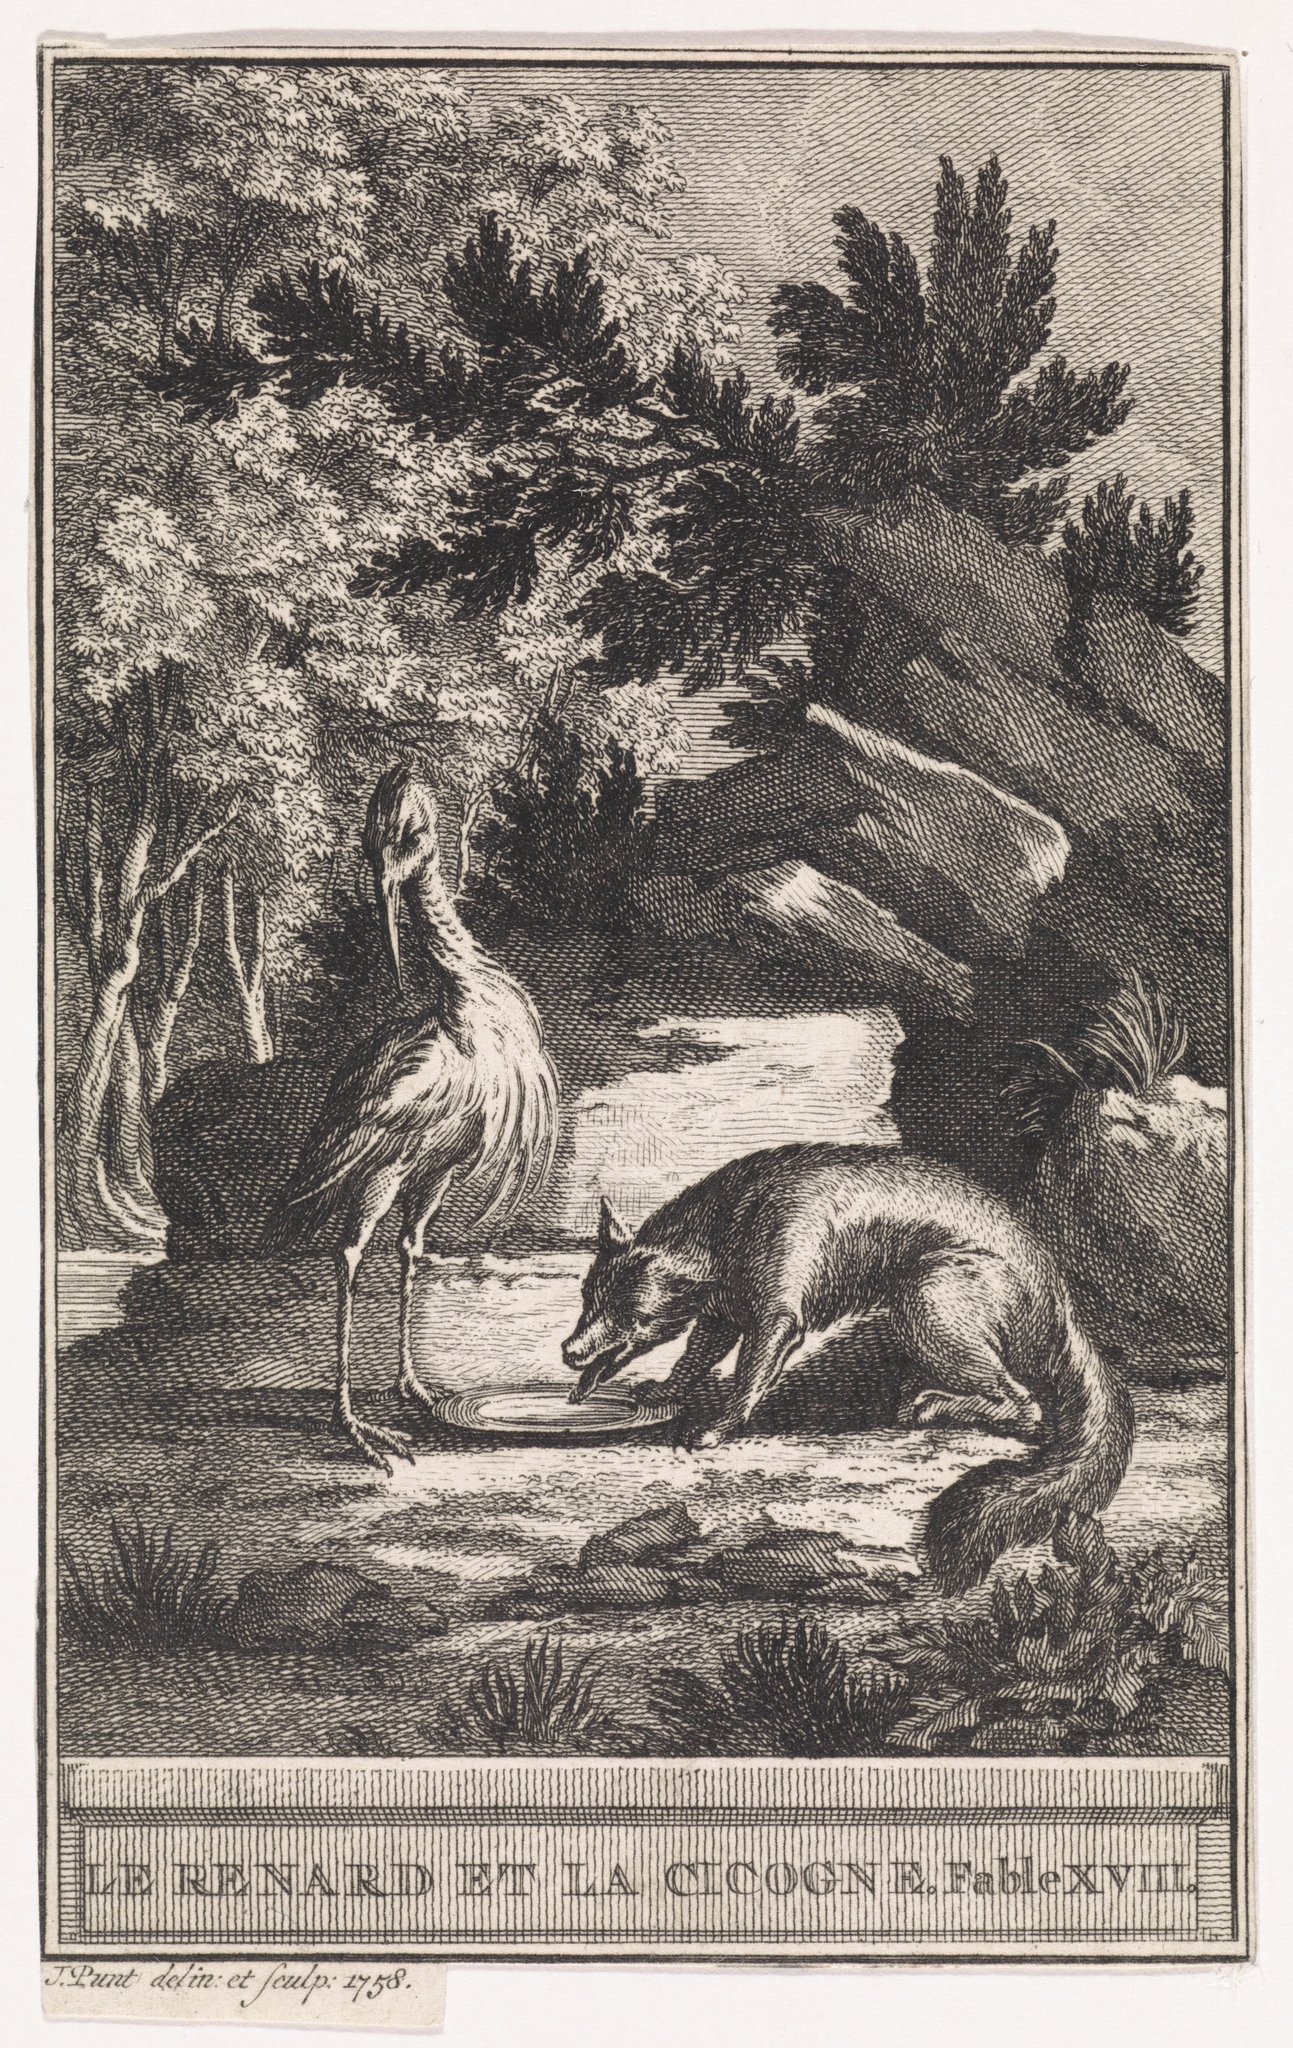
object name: book illustration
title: Le Renard et la Cicogne. Fable XVIII.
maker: jan punt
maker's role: draughtsman, print maker, publisher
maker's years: 1711-1779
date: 1758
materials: paper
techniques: engraving, etching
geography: amsterdam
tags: shore-birds and wading-birds: stork, specific works of literature, beasts of prey, predatory animals: fox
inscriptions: collector's mark: Lugt 2228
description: Prent gebruikt als illustratie in een of meerdere edities van: La Fontaine, Jean de. Fables choisies, deel I, p. 32. Leiden: Elie Luzac, 1764-1786. En in de editie uit Amsterdam: J. van Gulik, 1802.